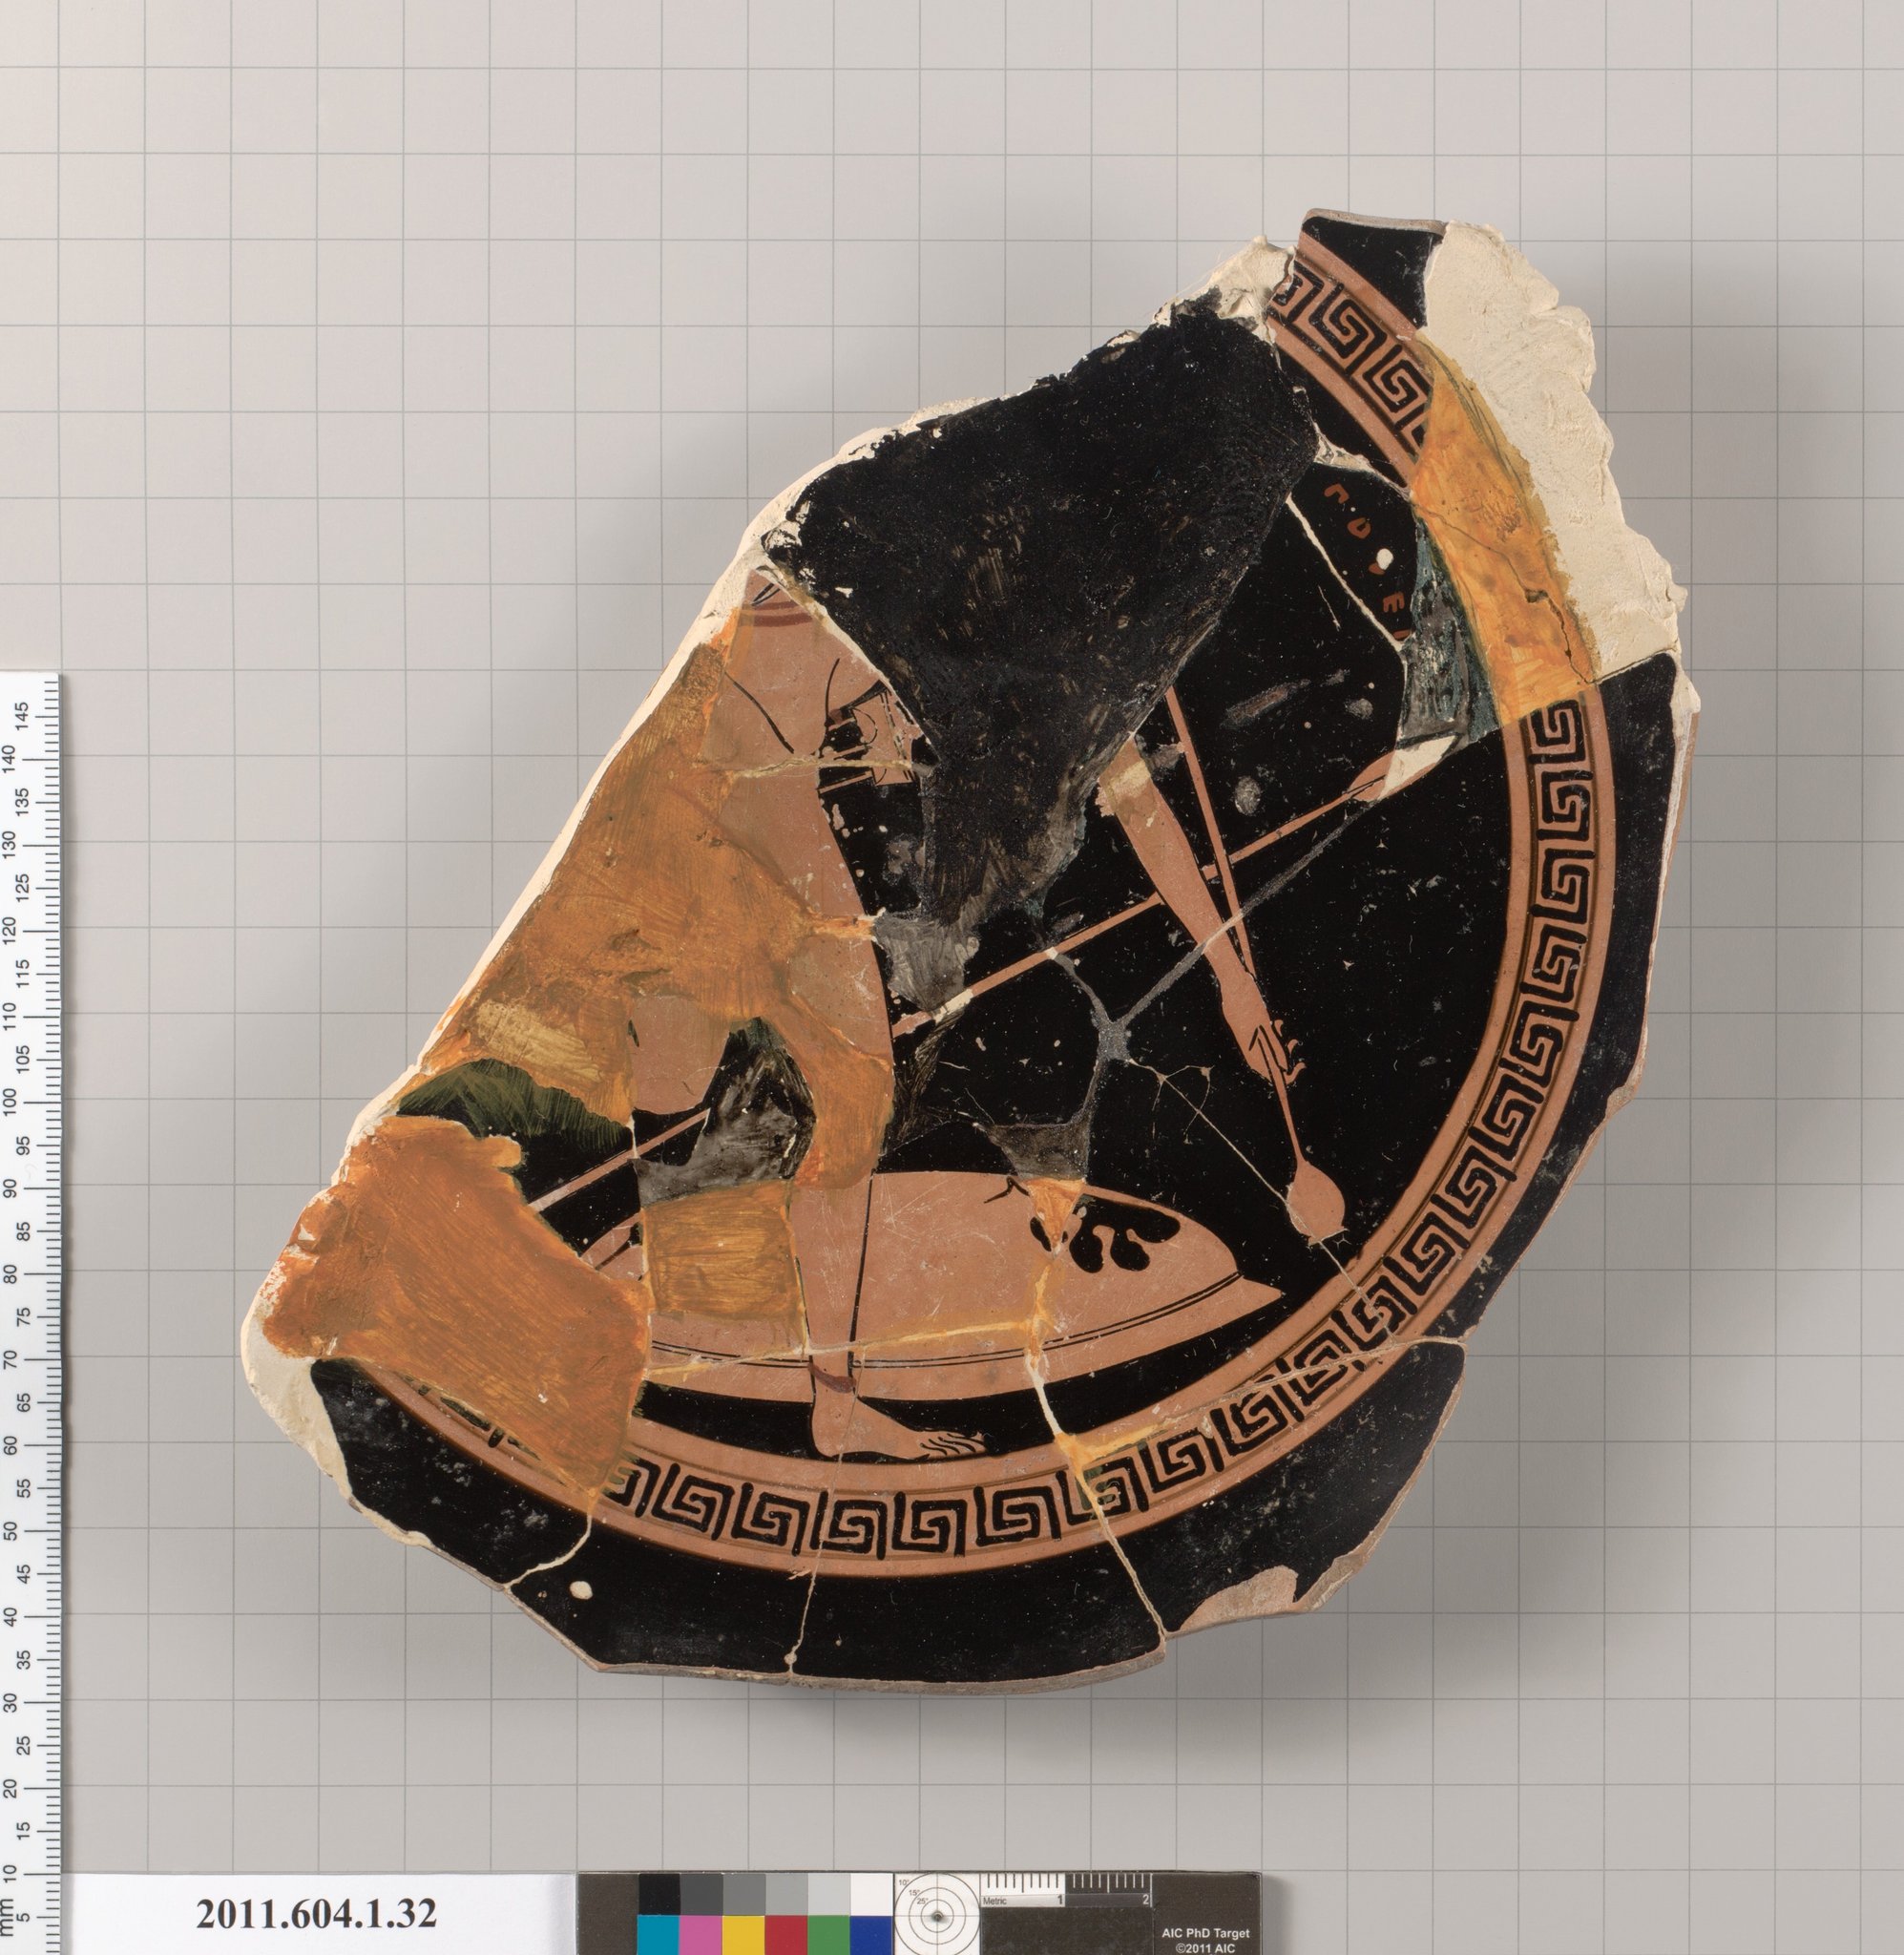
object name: kylix fragment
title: Terracotta fragment of a kylix (drinking cup)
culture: greek, attic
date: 490-480 BCE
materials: terracotta